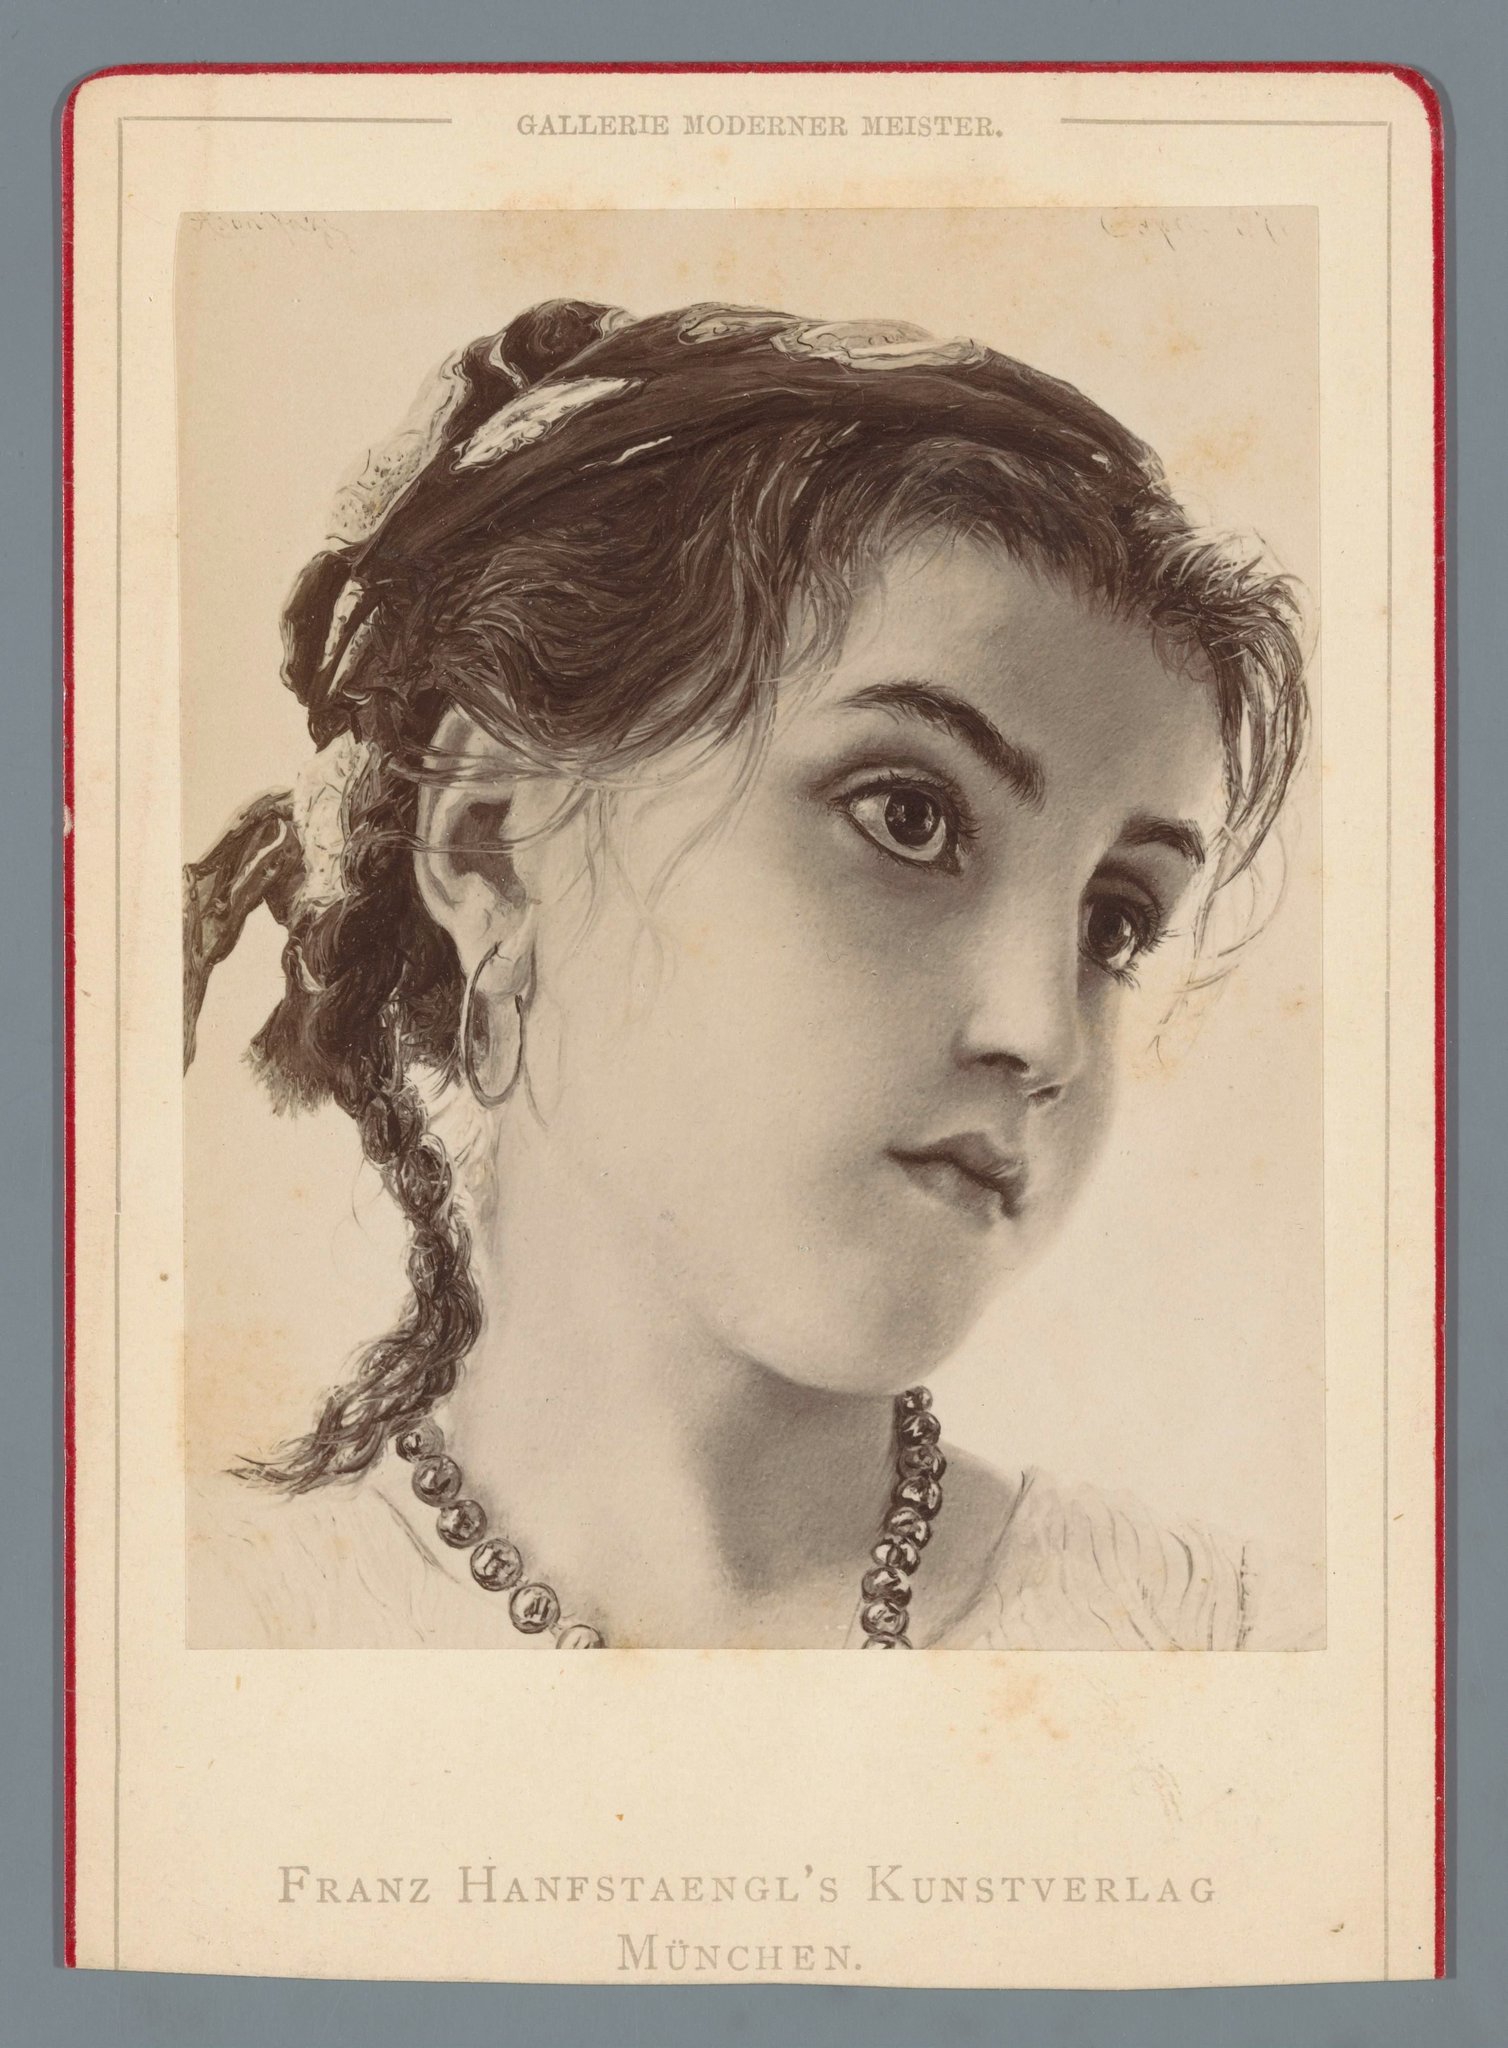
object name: reproduction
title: Gallerie Moderner Meister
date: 1870-1900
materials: cardboard, photographic support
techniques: albumen print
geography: munich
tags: child (at home) - aa - girl